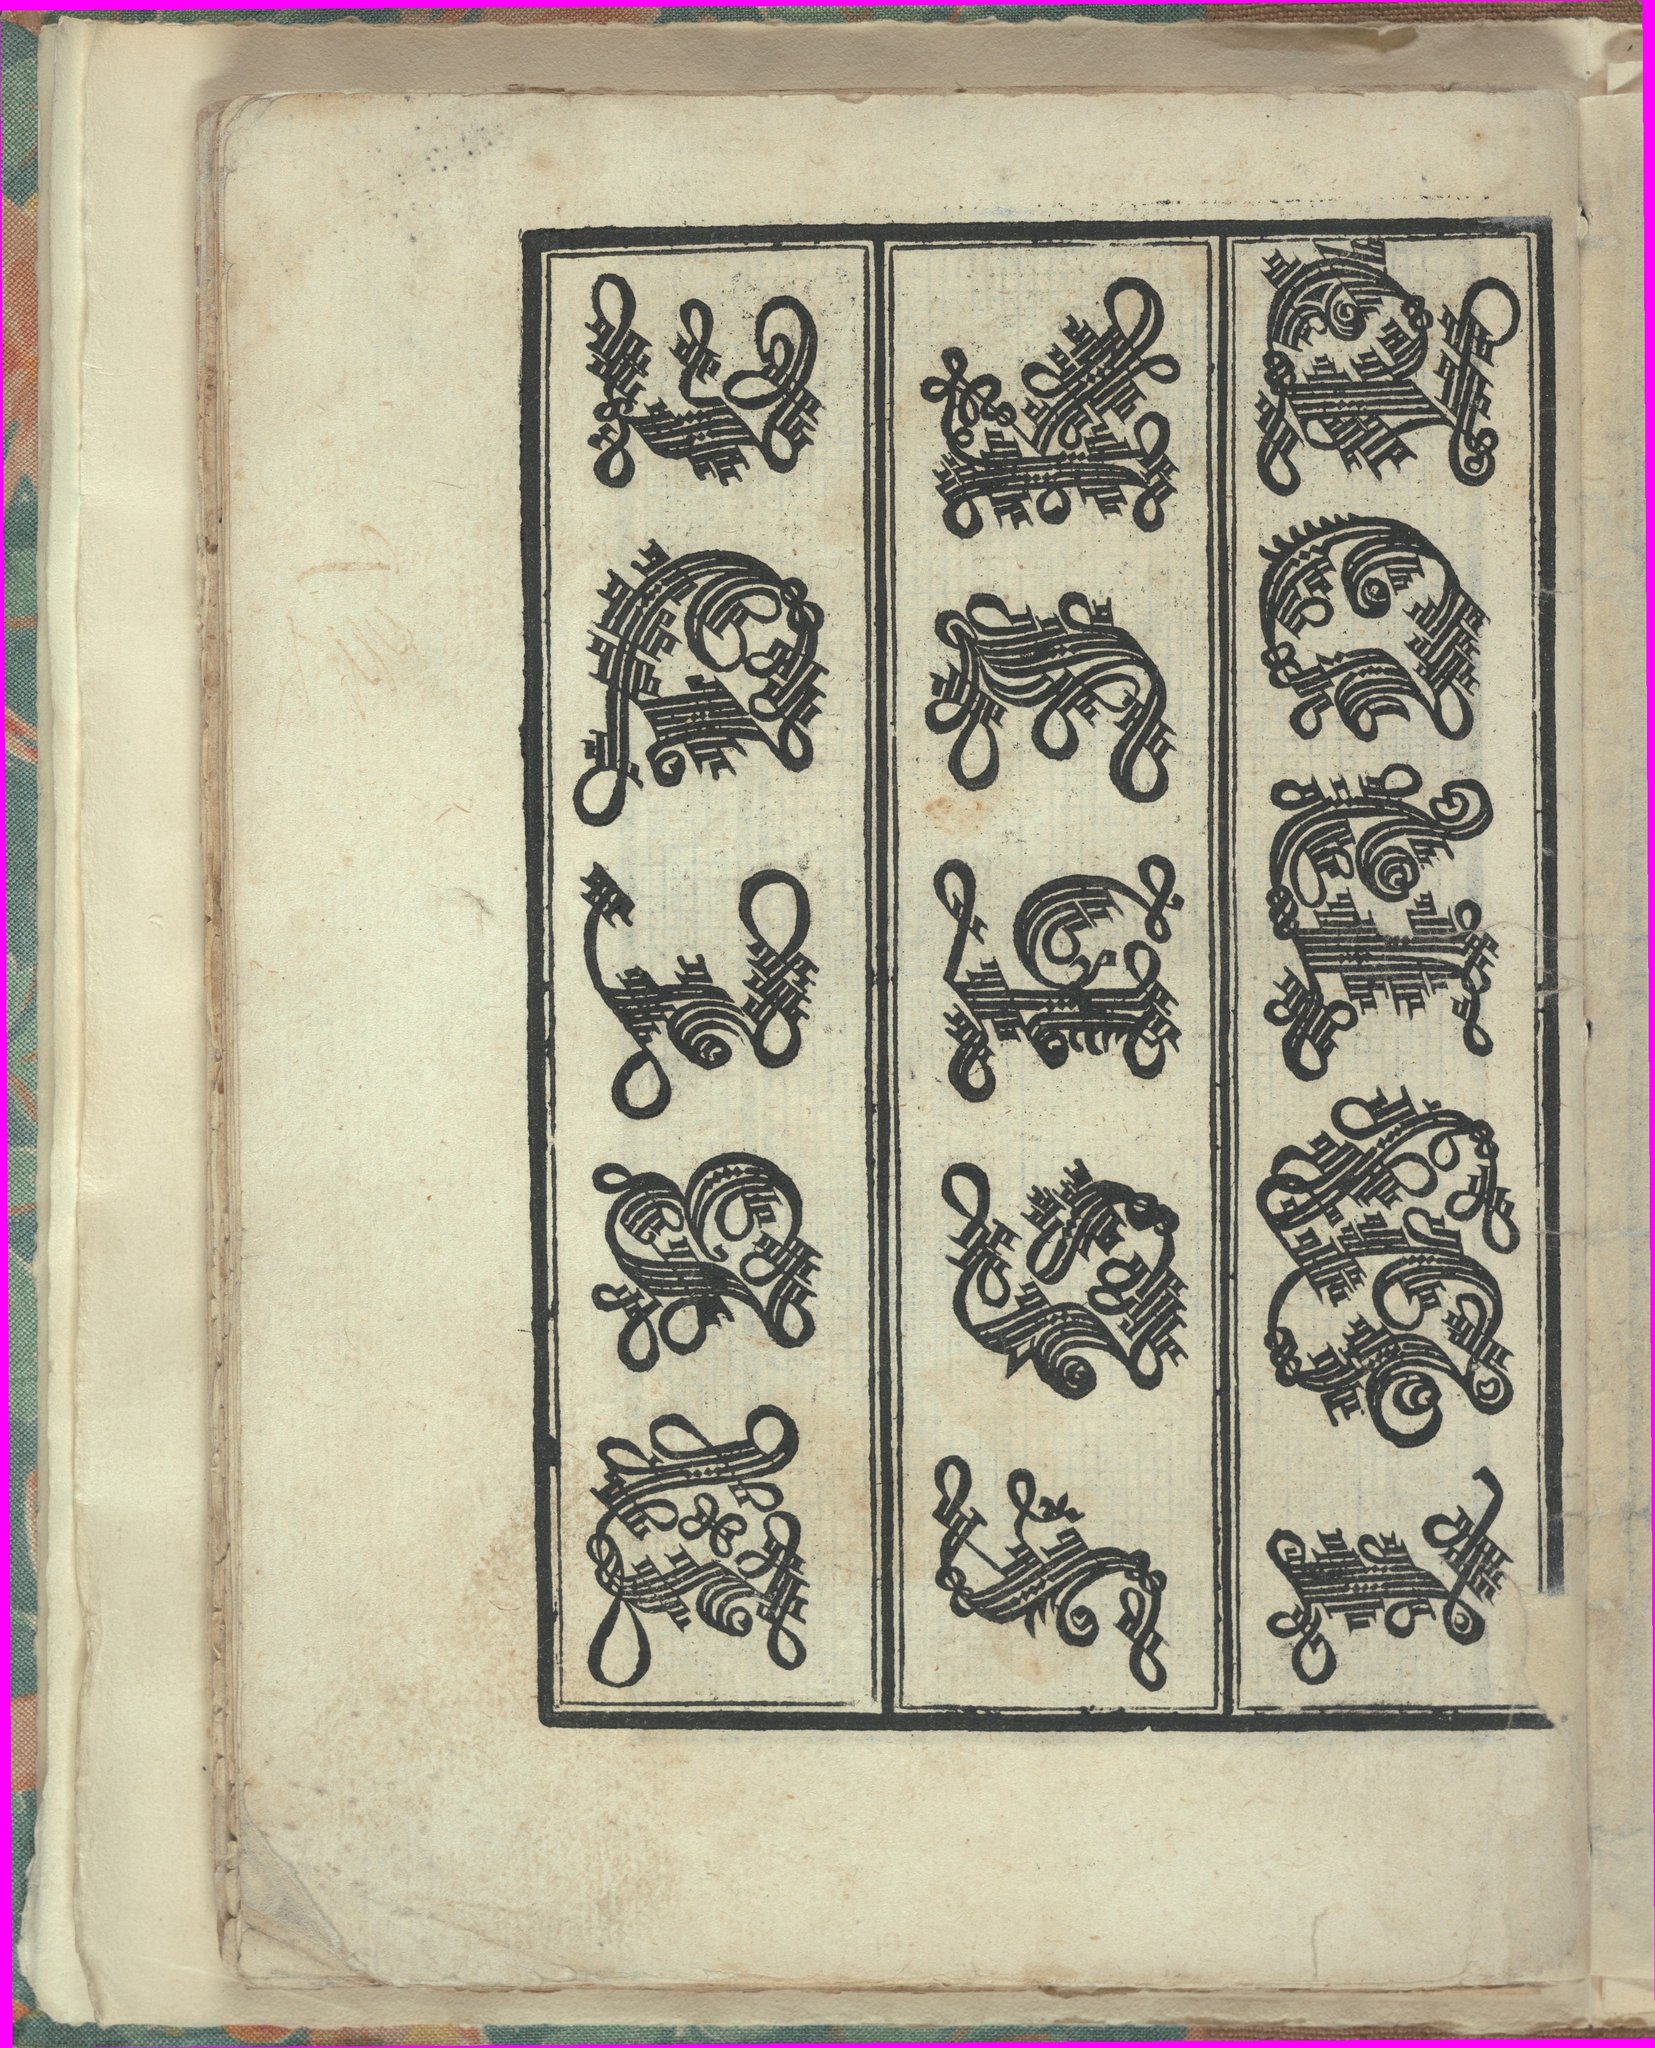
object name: book print ornament architecture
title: Opera Nova Universali intitulata Corona di racammi, page 37 (verso)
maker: giovanni andrea vavassore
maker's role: publisher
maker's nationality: italian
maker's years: 1530-1573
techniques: woodcut